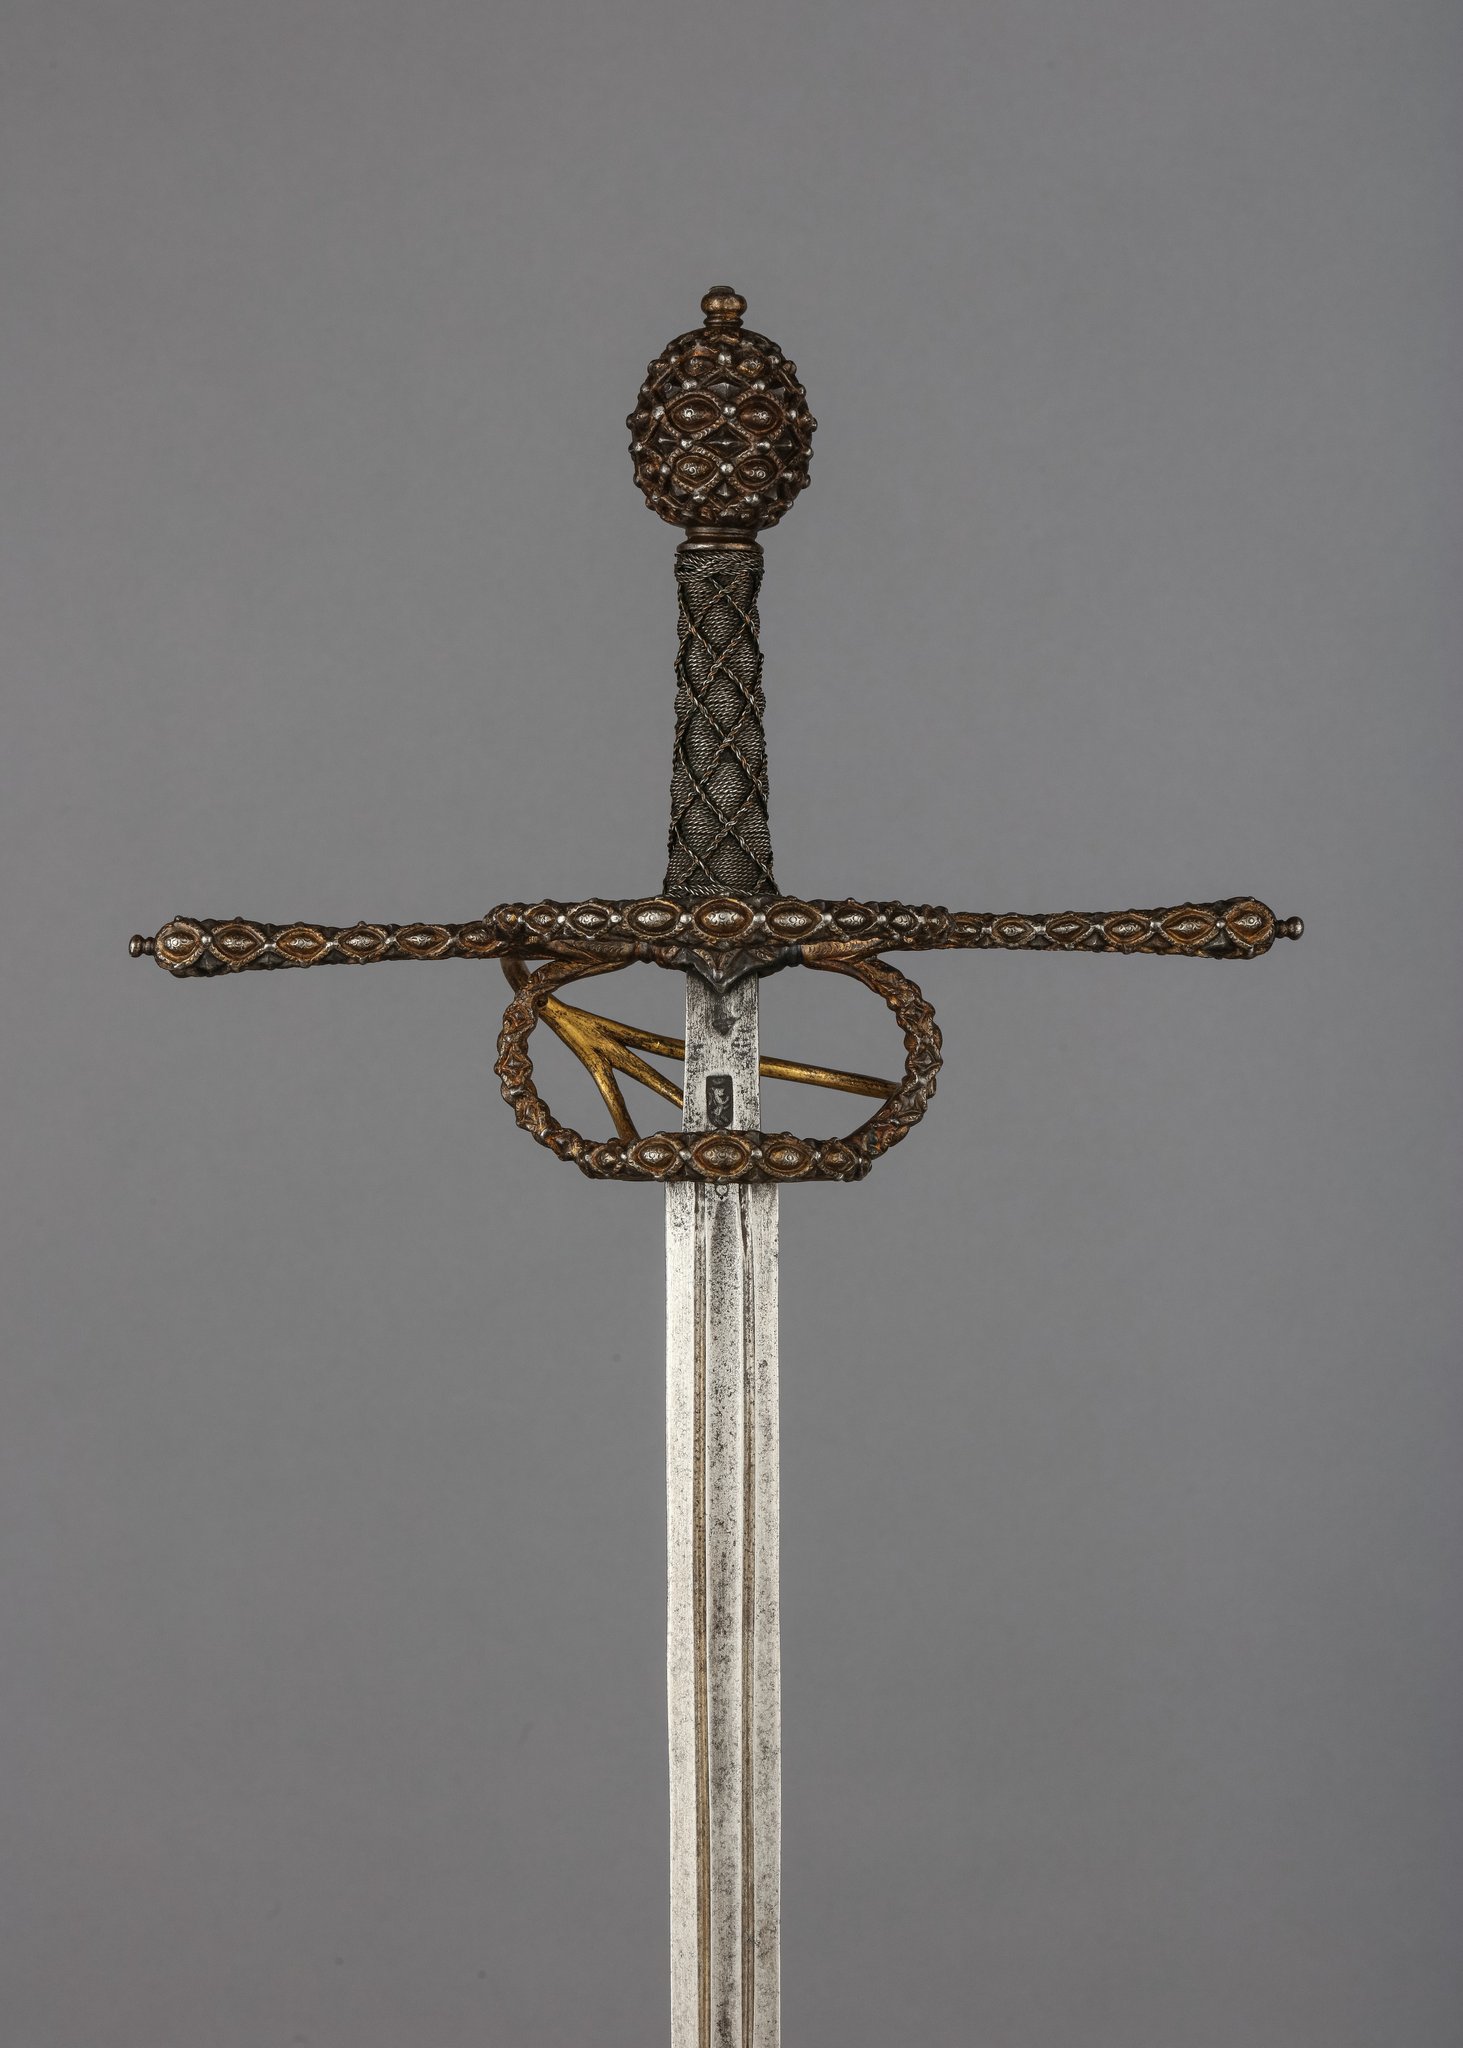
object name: rapier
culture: italian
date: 1580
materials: gold, iron, steel, wood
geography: italy